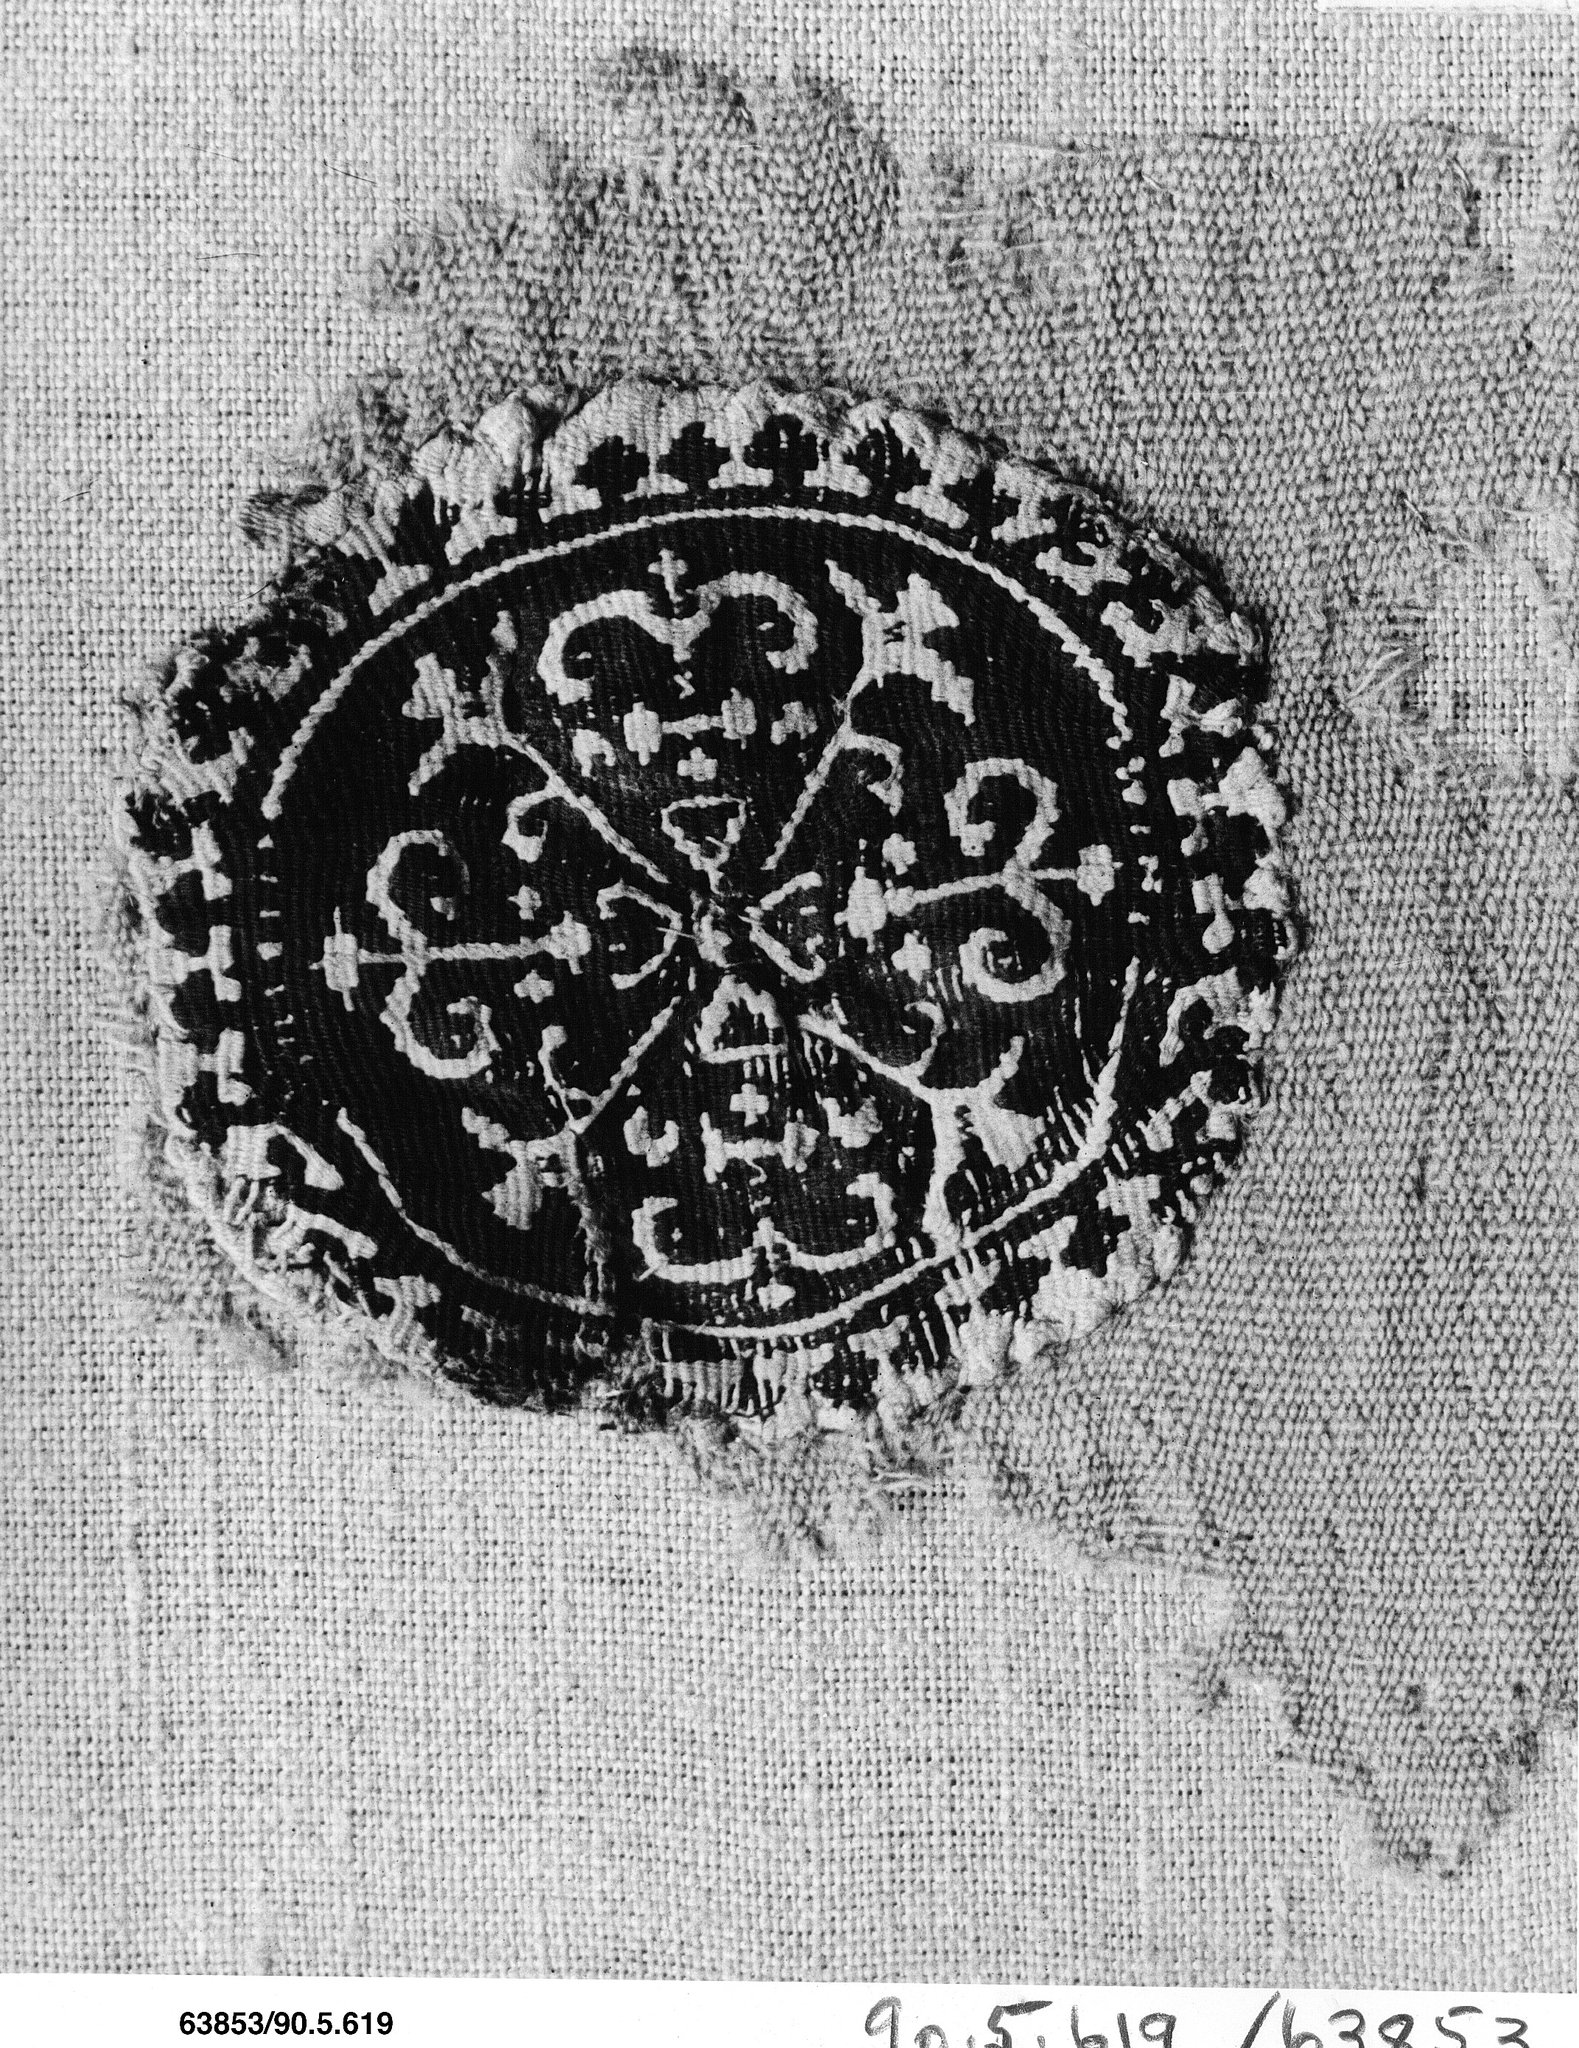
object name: textile fragment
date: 301-400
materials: linen, wool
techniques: weave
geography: egypt